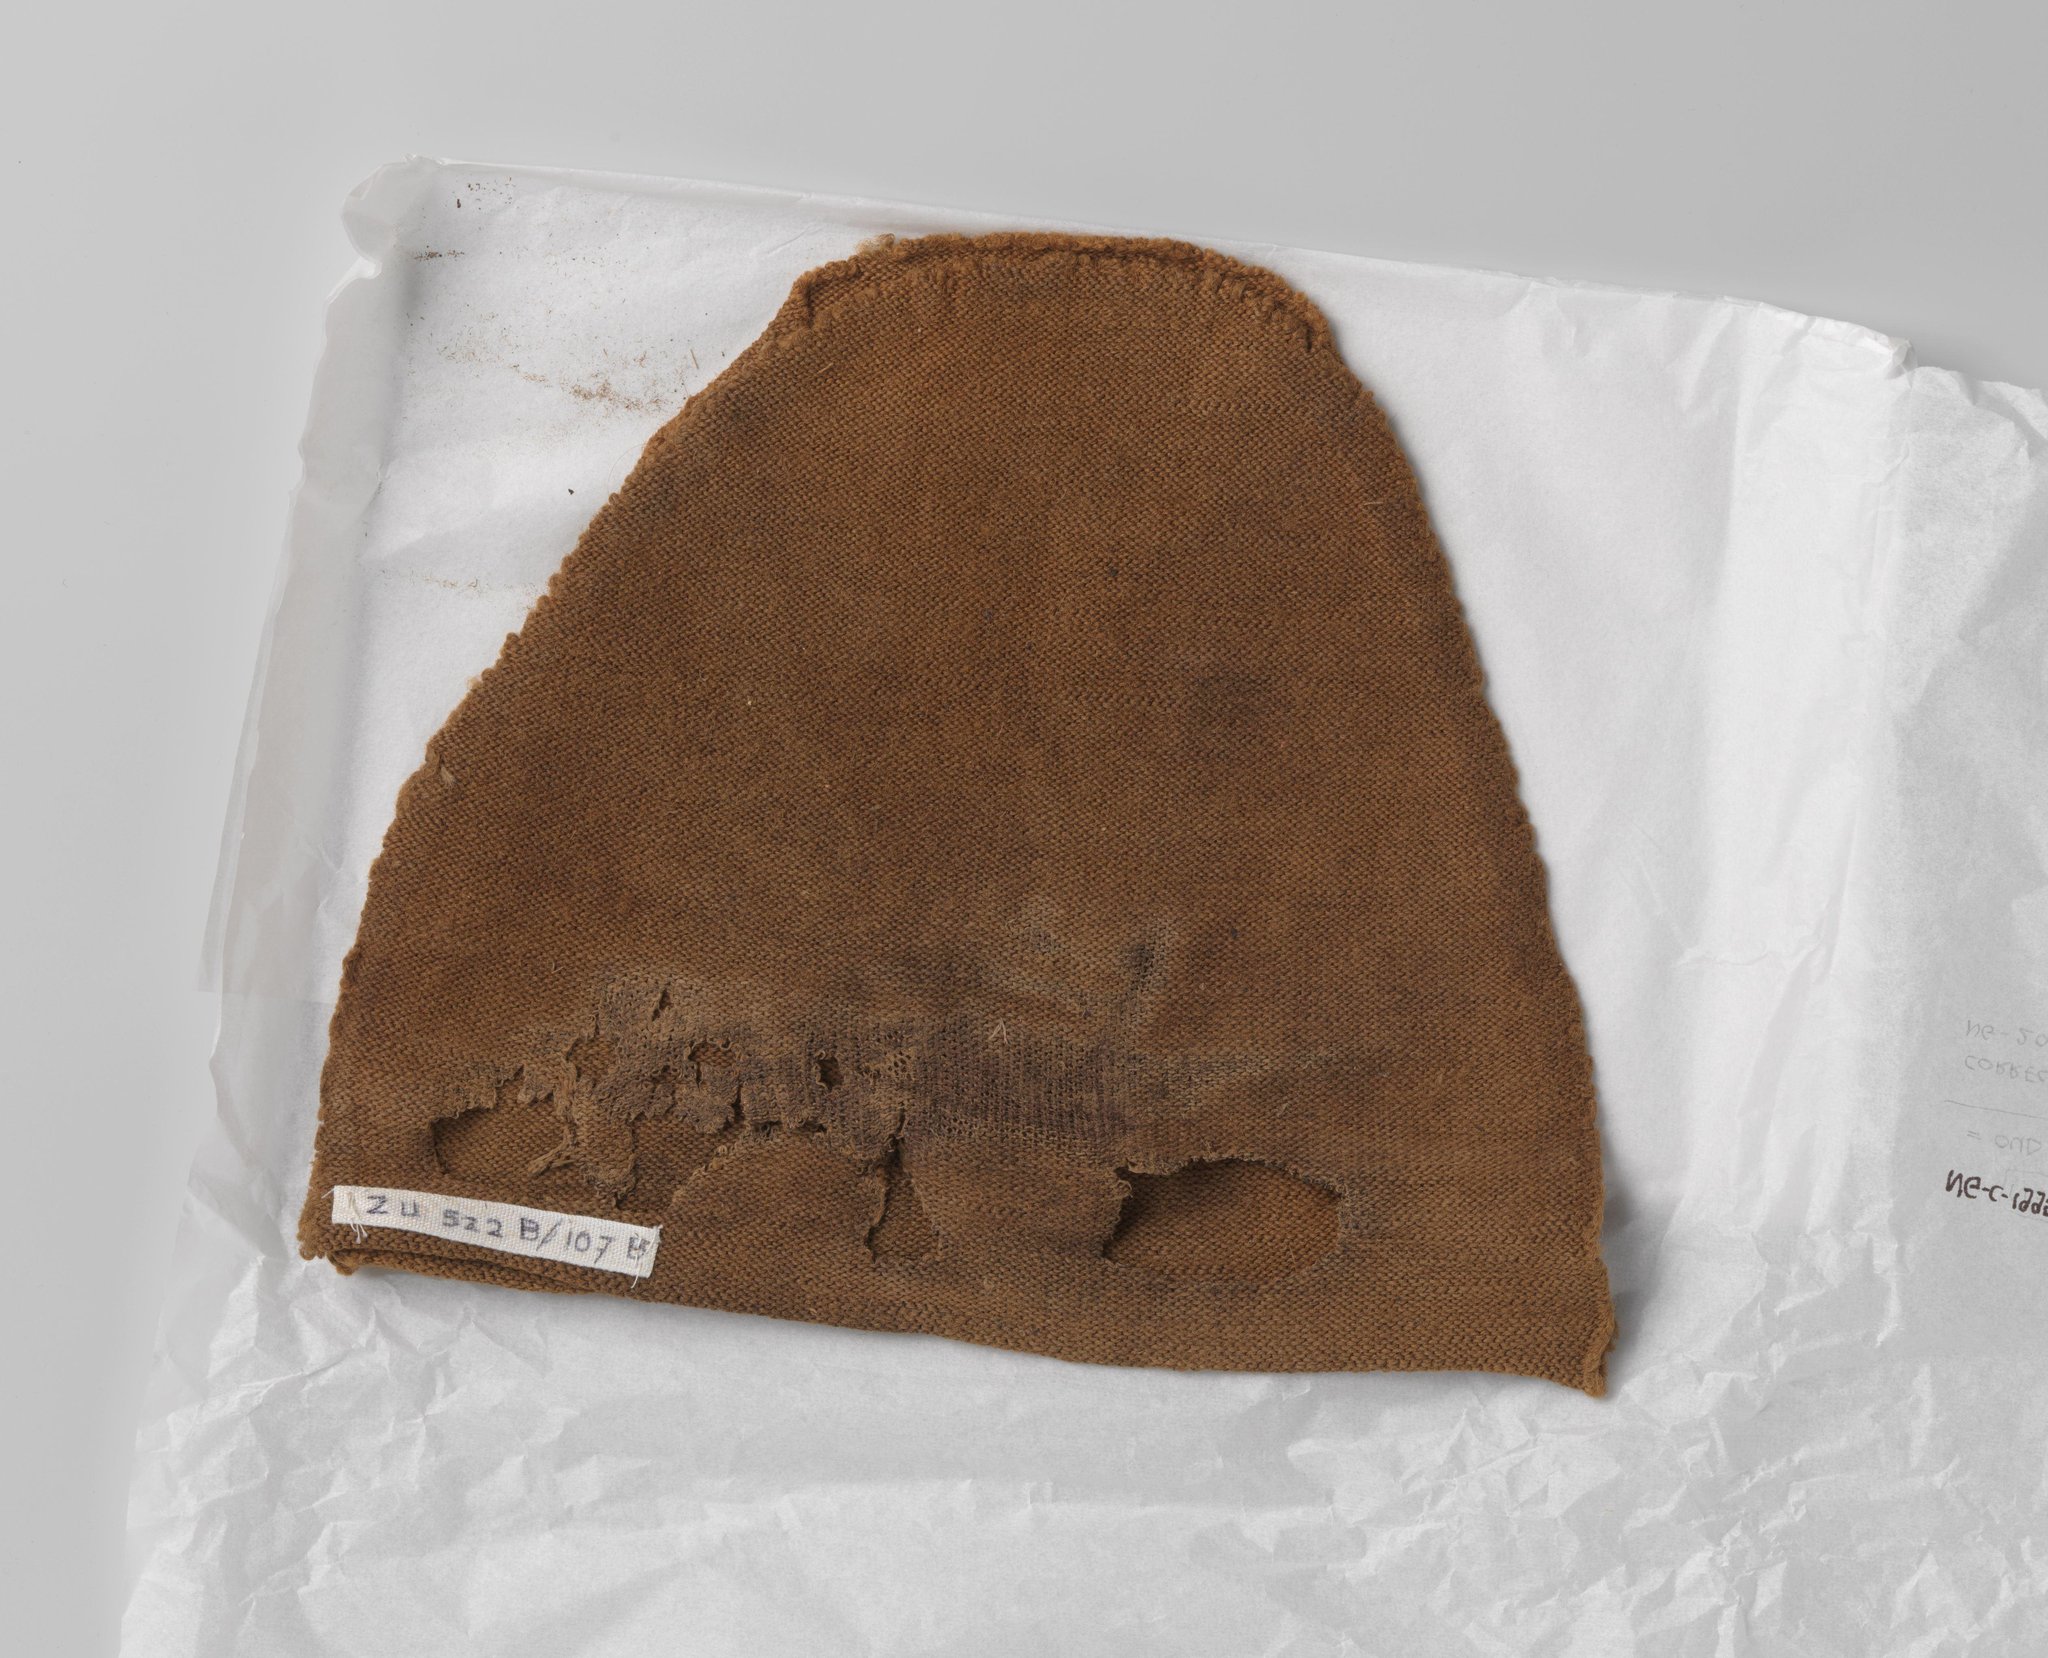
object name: cap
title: Muts, twee helften, fijn gebreid van lichtbruine wol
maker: Anonymous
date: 1650-1800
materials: wool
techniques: knitting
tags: noordse compagnie, spitsbergen, zeeuwsche uytkyck, svalbard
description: Muts, twee helften, fijn gebreid van lichtbruine wol. Gebreid in tricot-steek, de rand in averechte steek. De twee delen waren op elkaar genaaid, maar nu los.